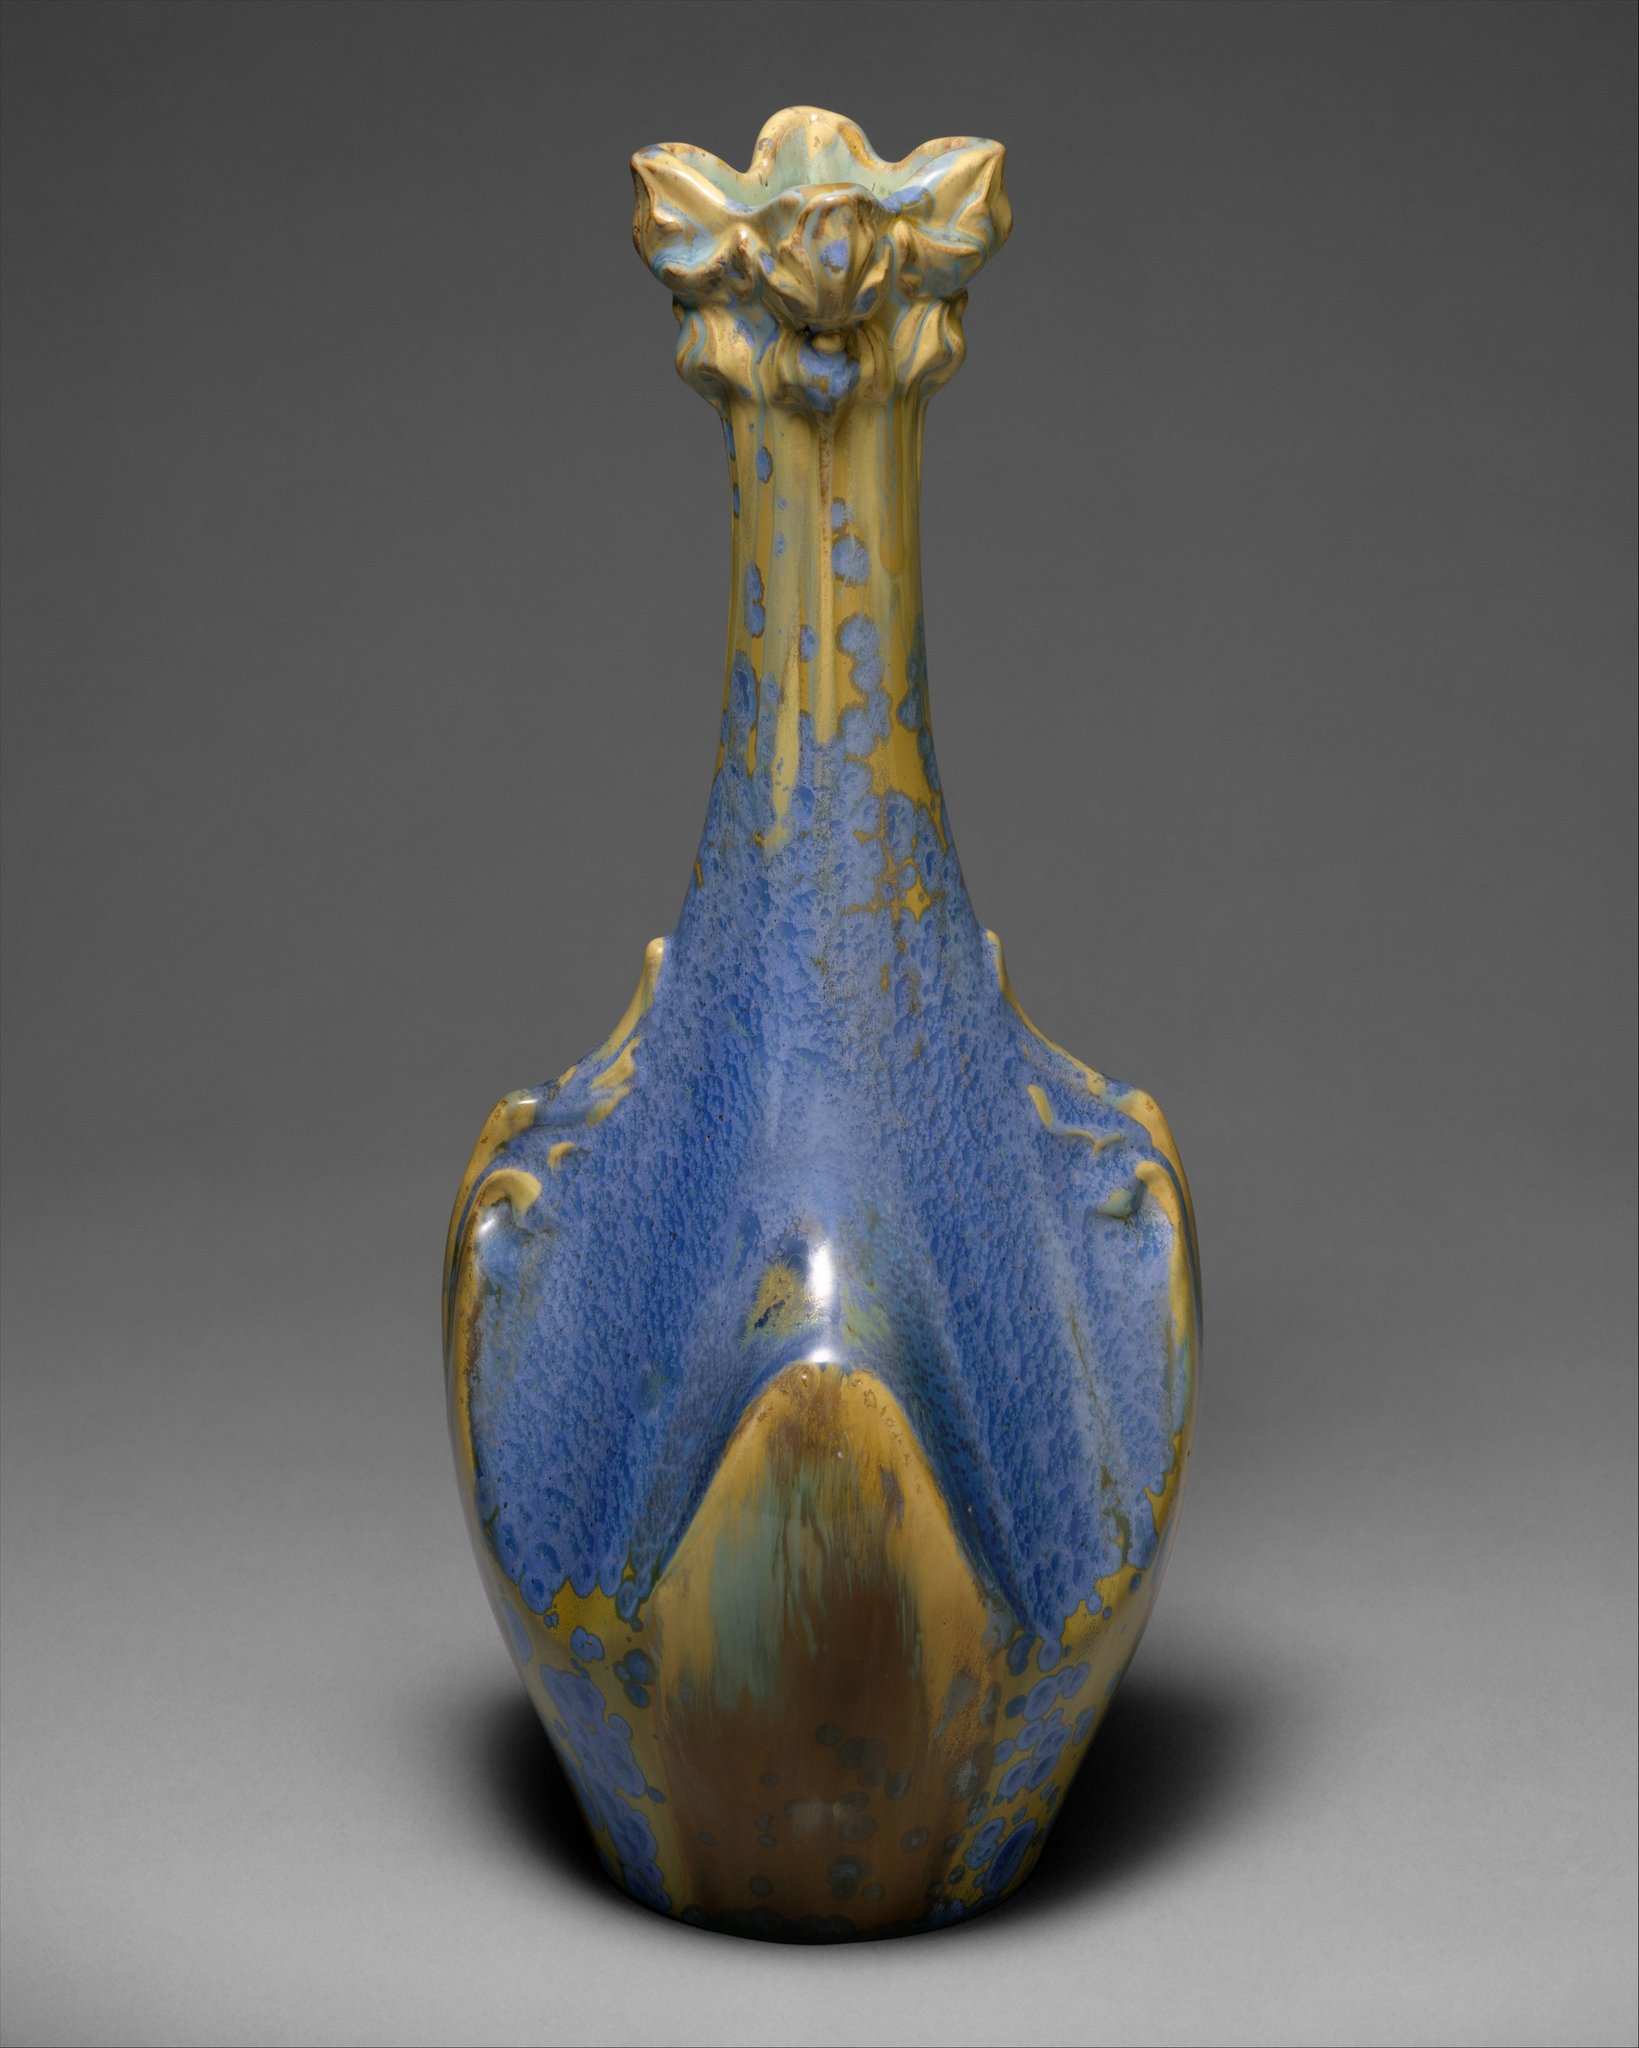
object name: vase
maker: factory of olivier de sorra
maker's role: factory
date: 1885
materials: stoneware